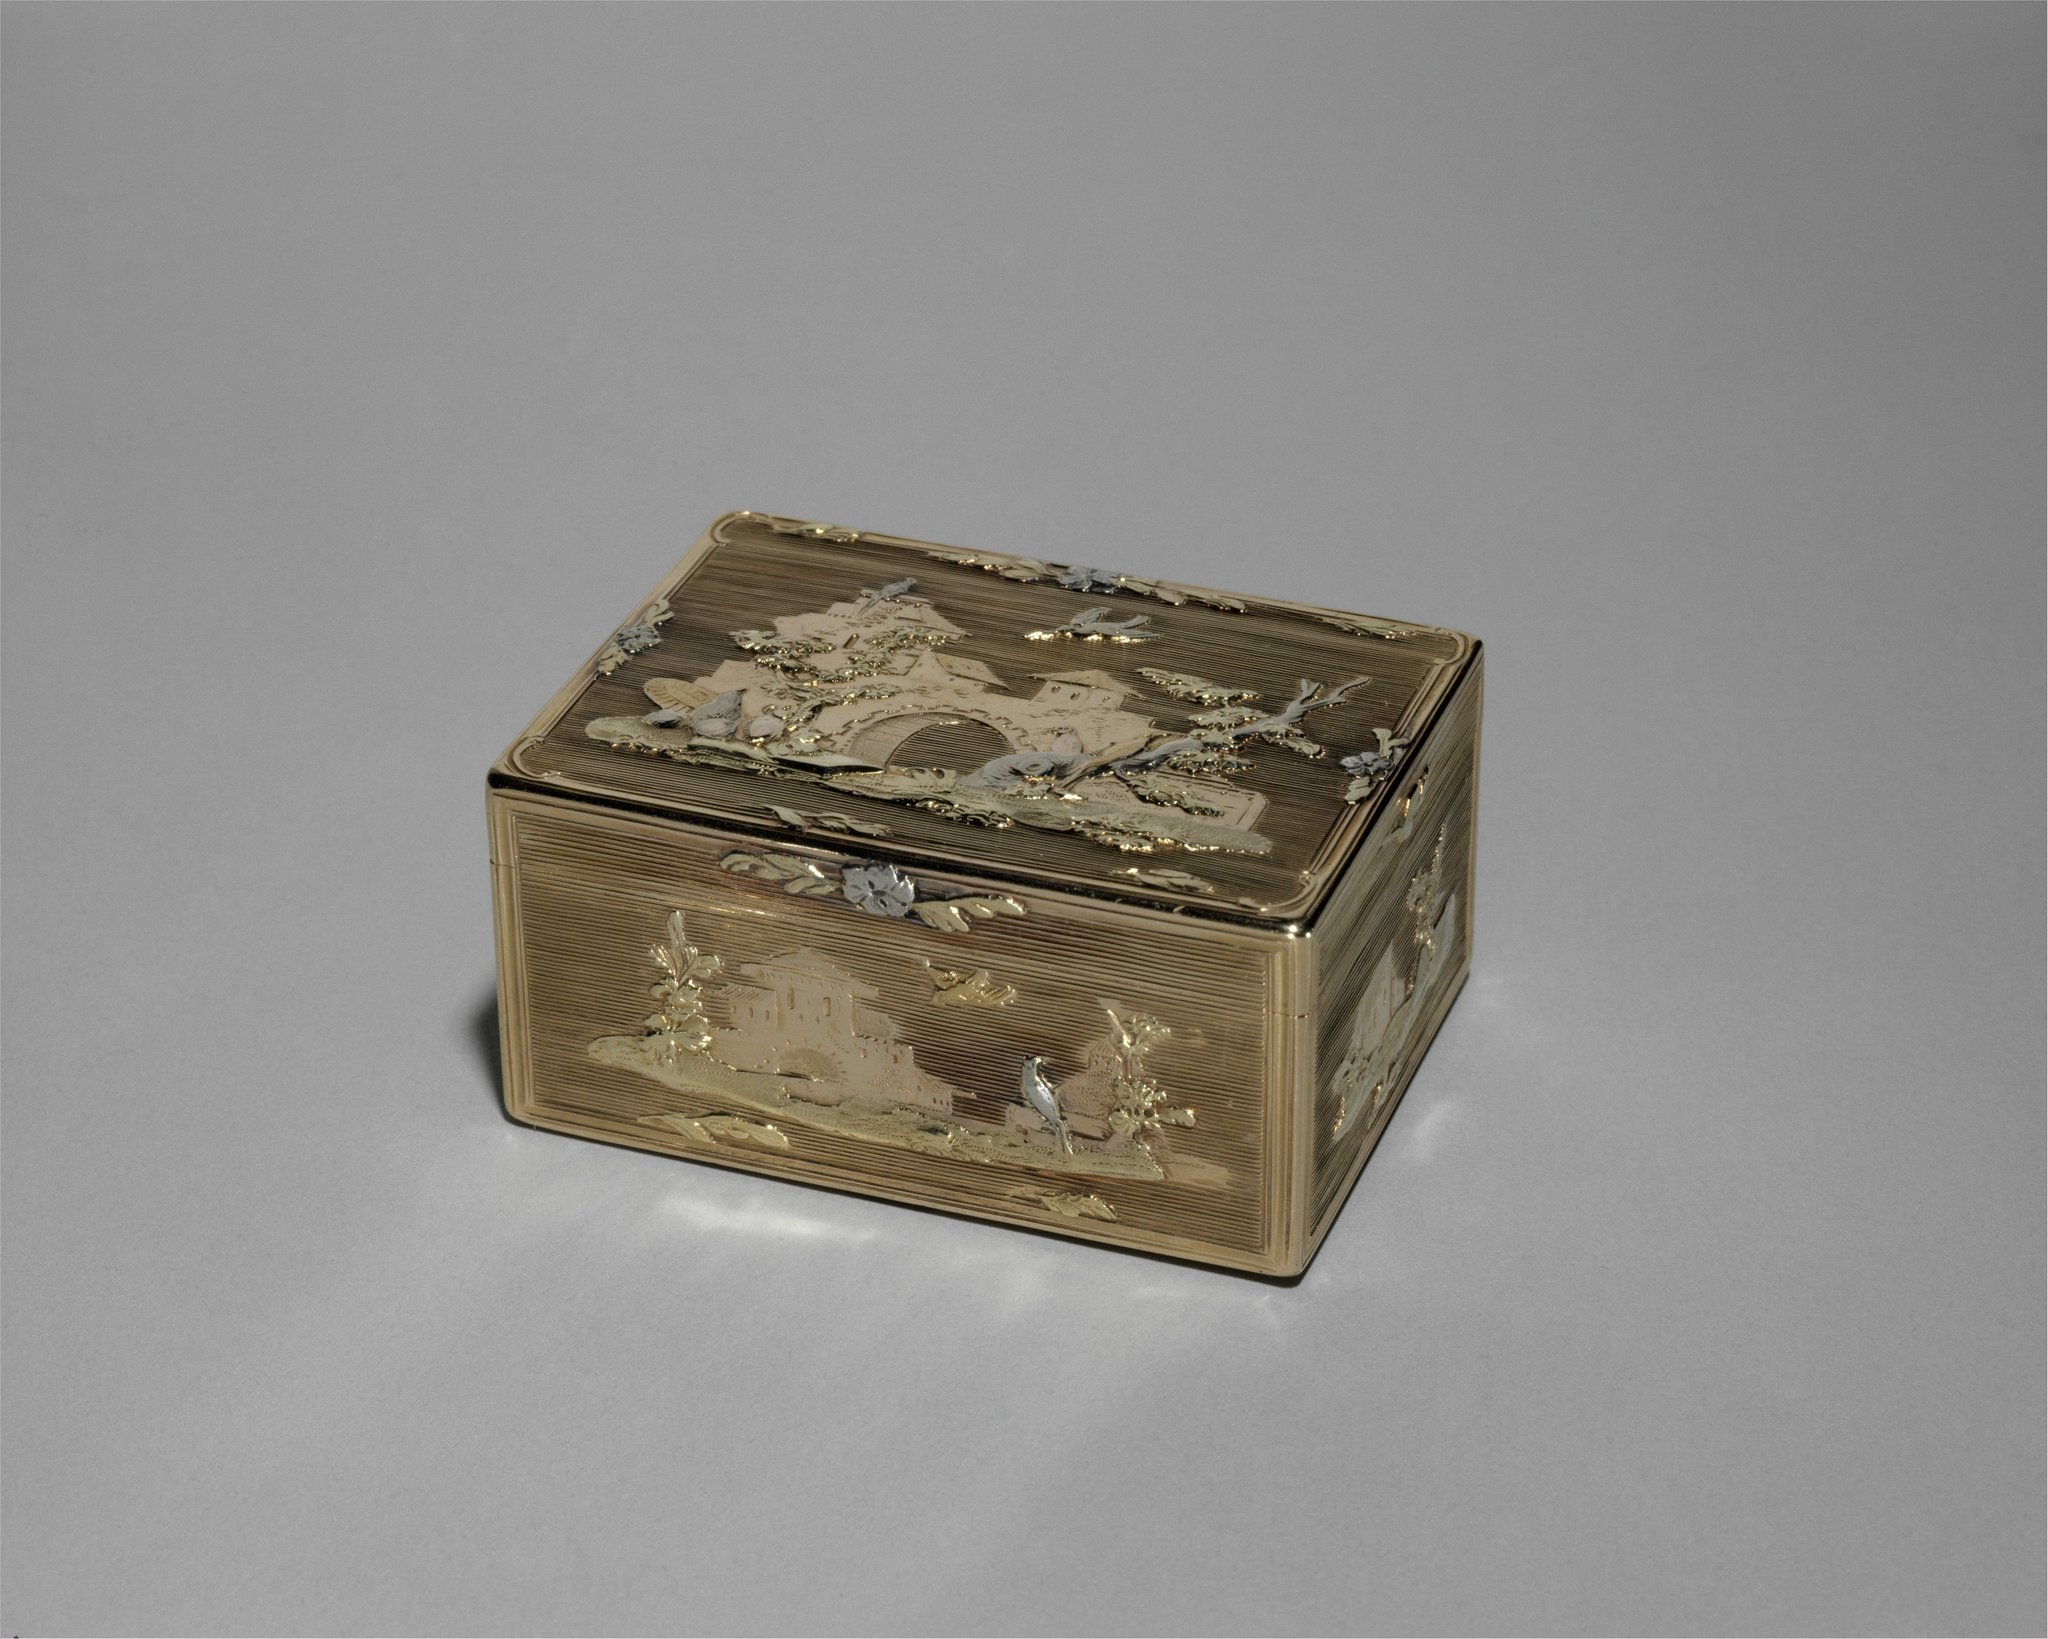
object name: snuffbox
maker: charles le bastier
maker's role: maker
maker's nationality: french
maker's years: 1724-1783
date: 1760-1761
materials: gold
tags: houses